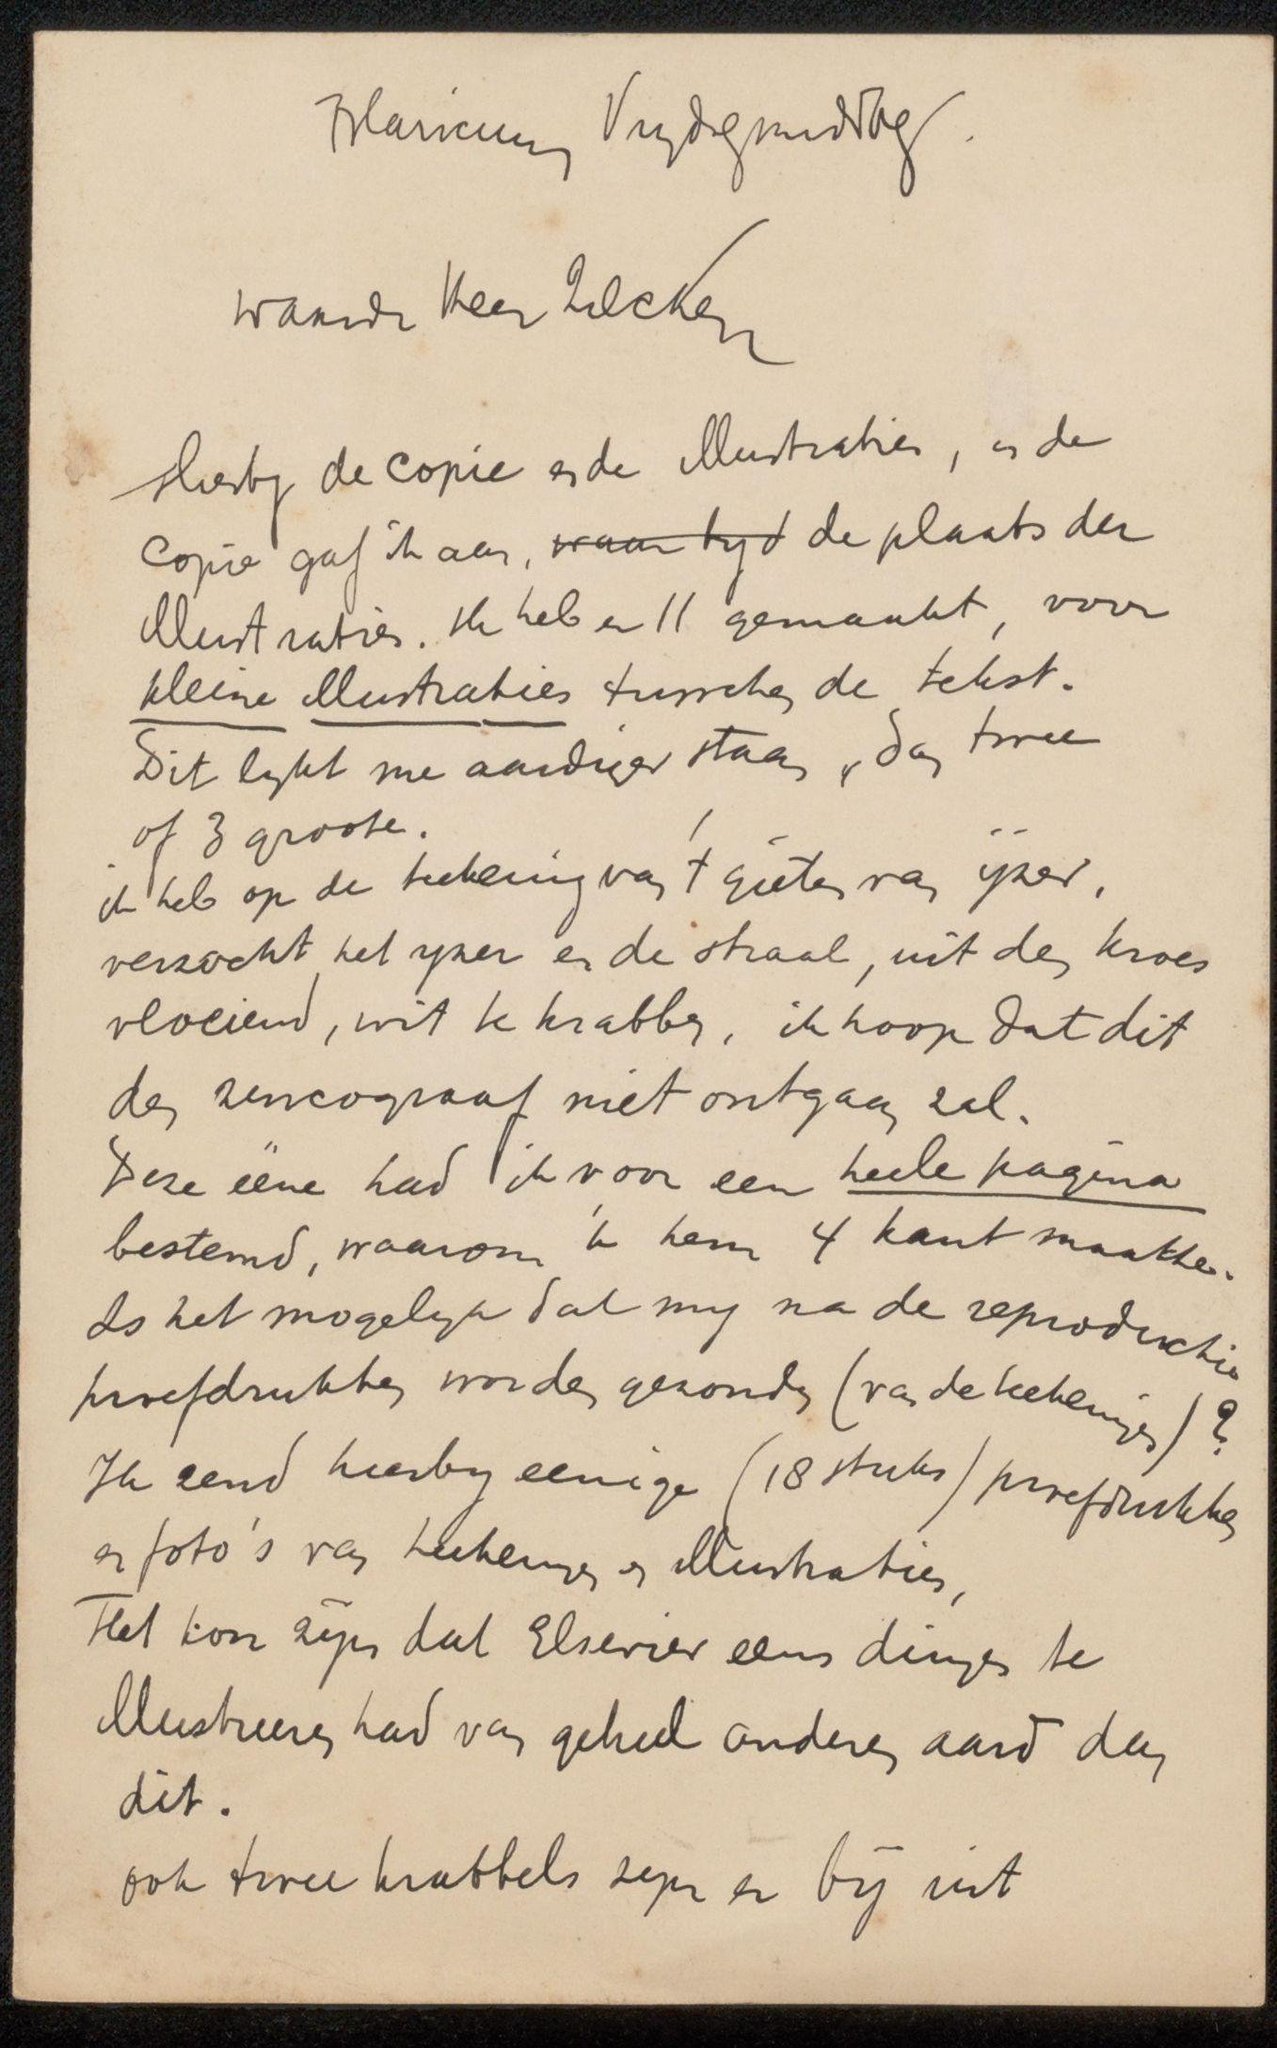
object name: letter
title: Brief aan Philip Zilcken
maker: jan de waardt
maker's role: draughtsman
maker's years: 1871-1909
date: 1881-1909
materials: ink, paper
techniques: pen, writing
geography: blaricum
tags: painter, draughtsman, philip zilcken, illustration ~ printed matter, book, belgium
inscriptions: collector's mark: ‘RPK’